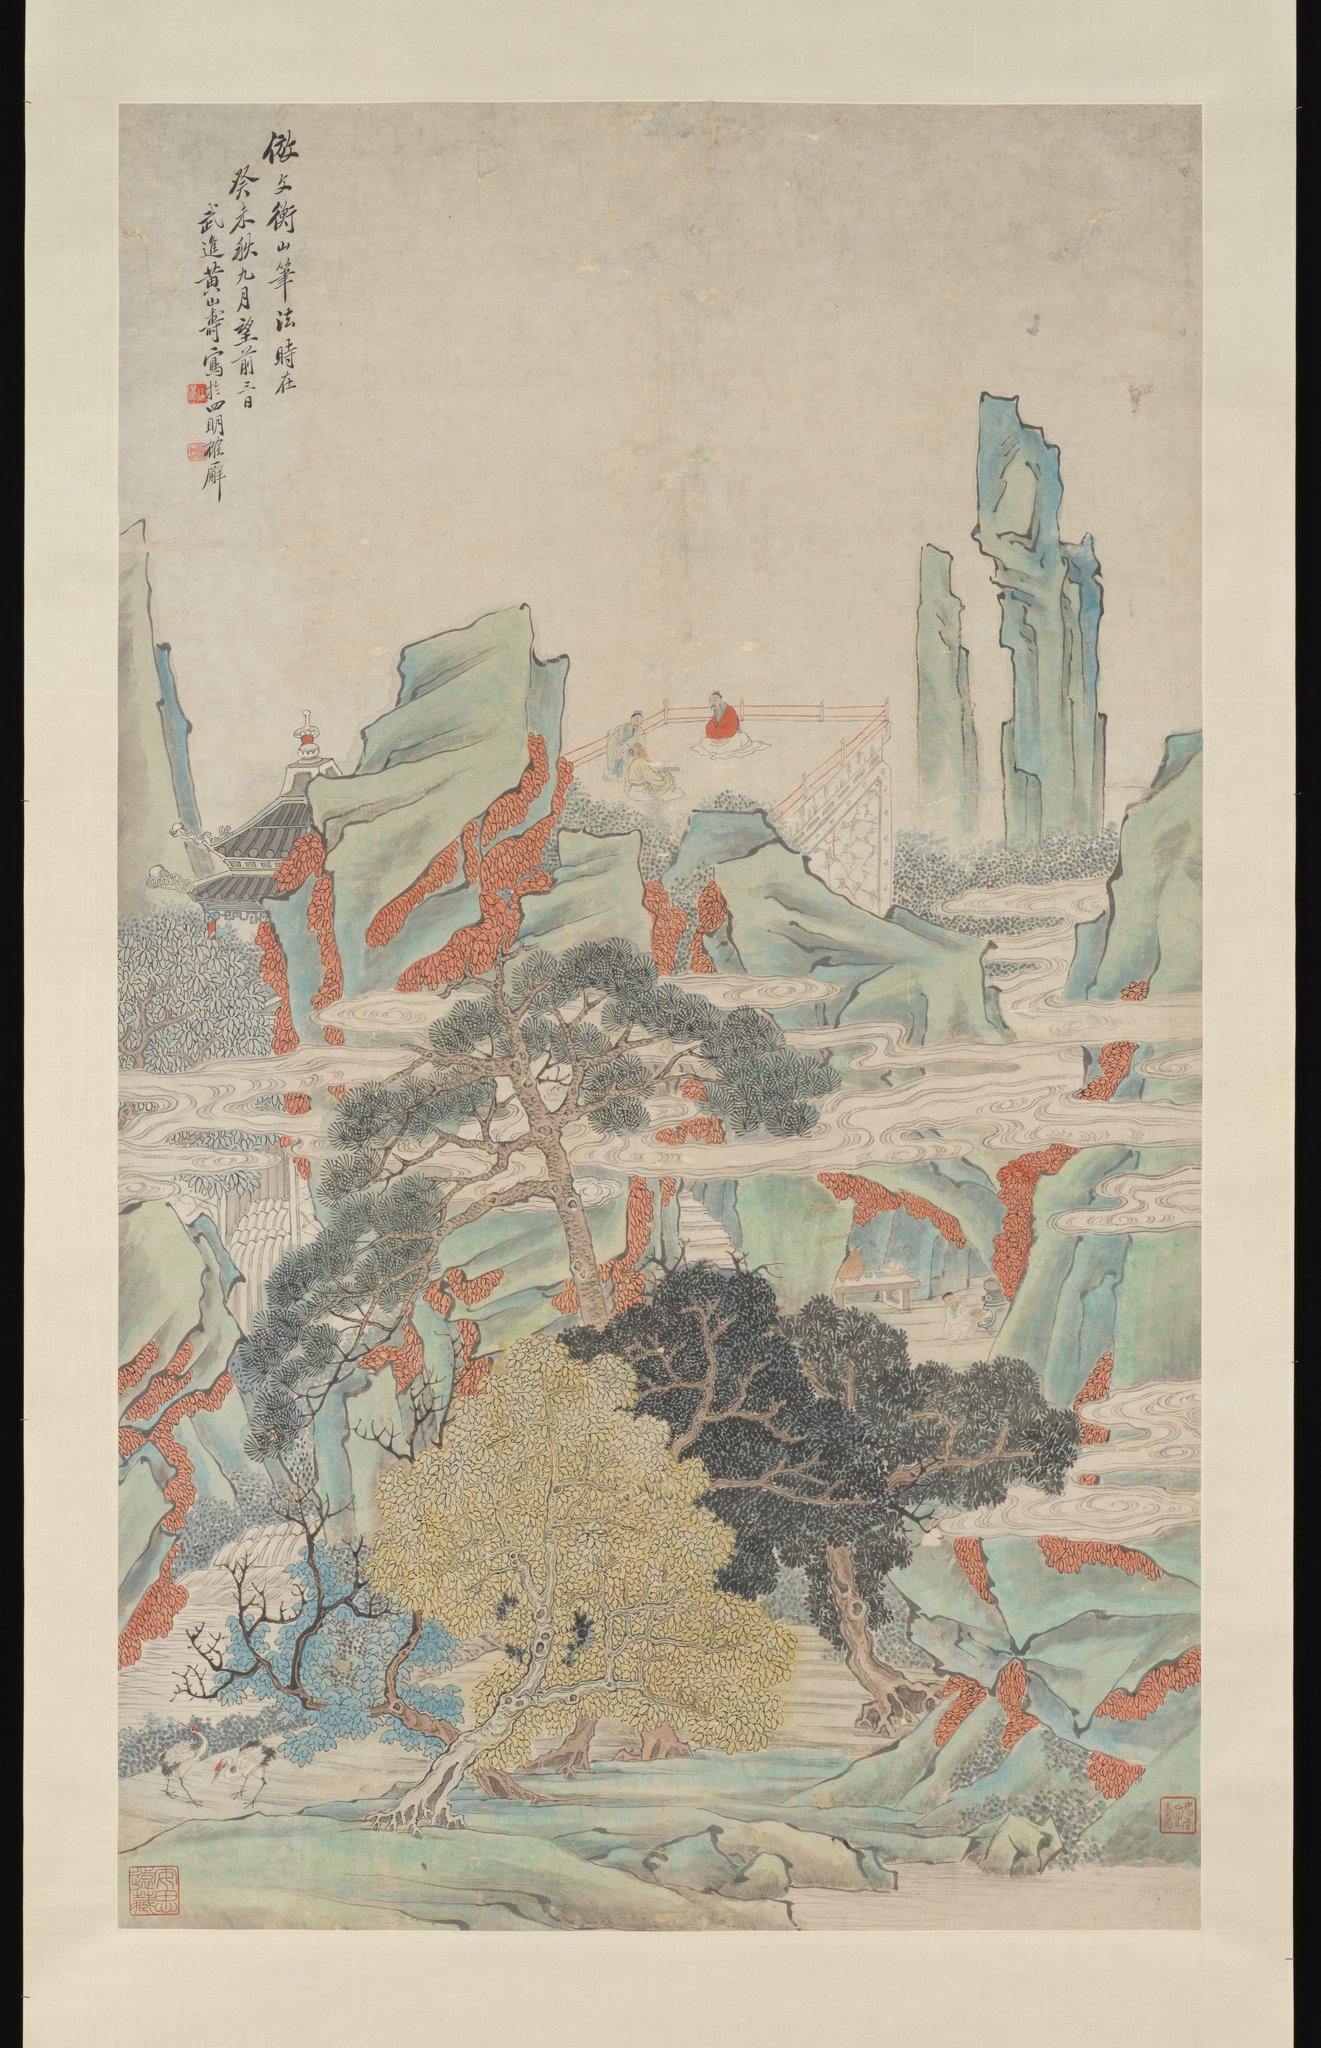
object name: hanging scroll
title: Heavenly Cave in the Immortal World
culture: chinese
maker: huang shanshou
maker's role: artist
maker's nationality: chinese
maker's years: 1855-1919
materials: ink, paper